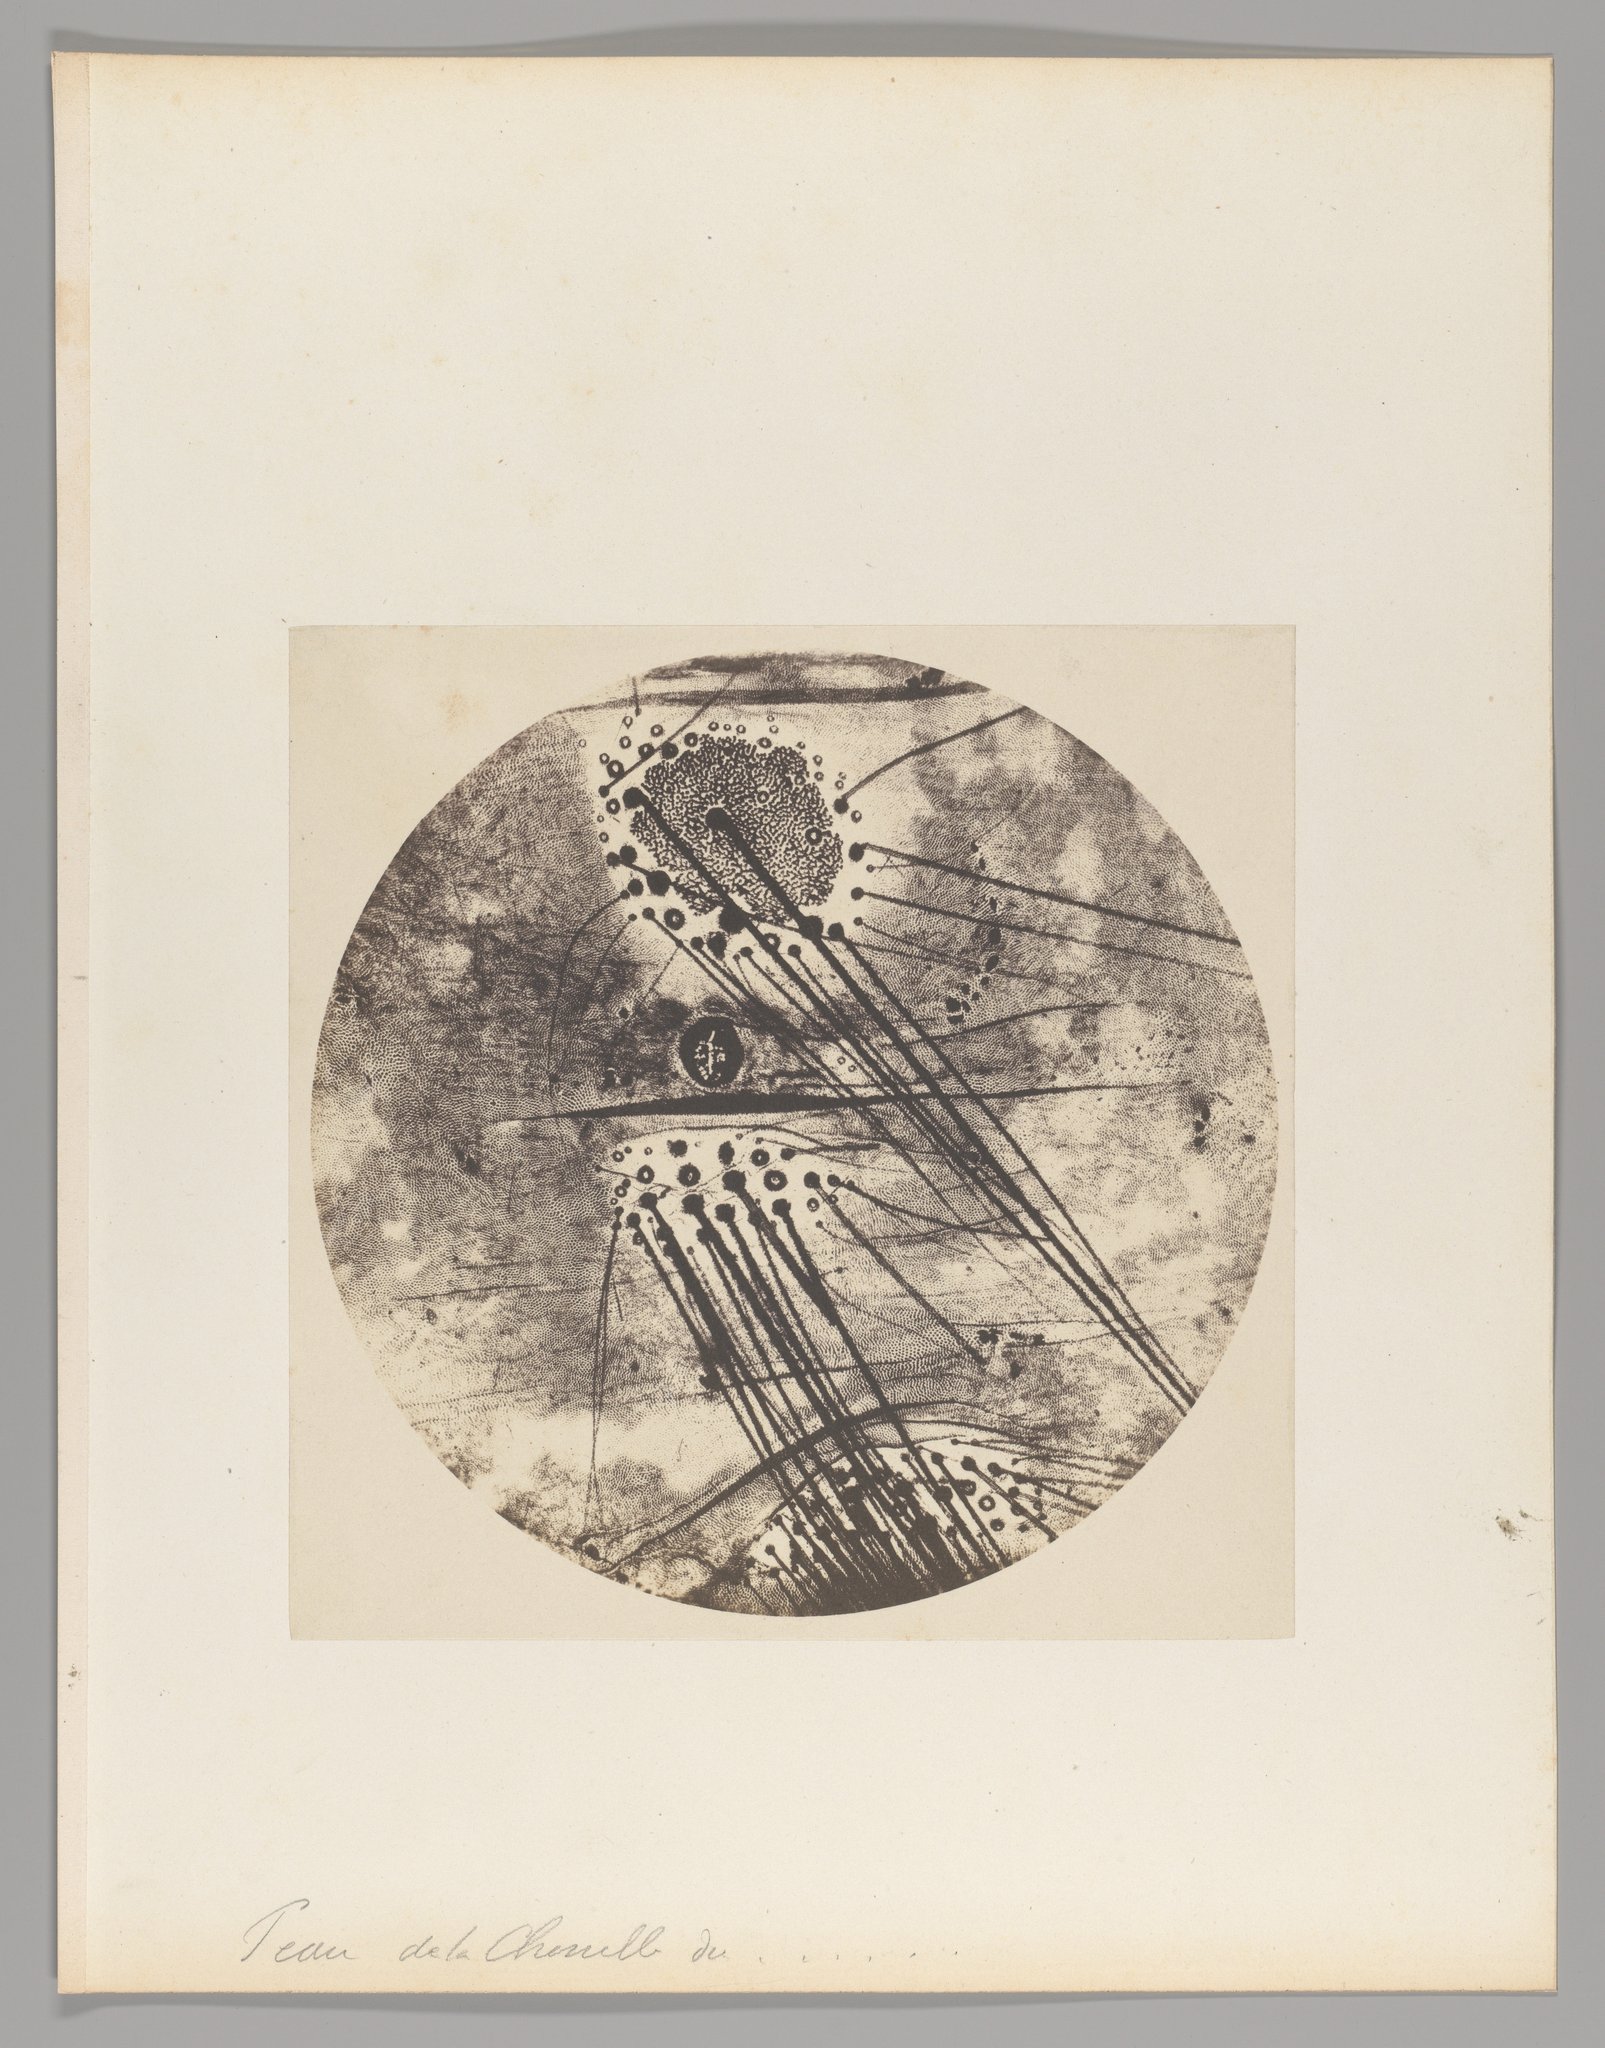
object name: photograph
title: Peau de la chenille [Caterpillar Skin]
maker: auguste-adolphe bertsch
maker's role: artist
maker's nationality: french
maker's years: 1813-1871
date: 1853-1857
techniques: salted paper print